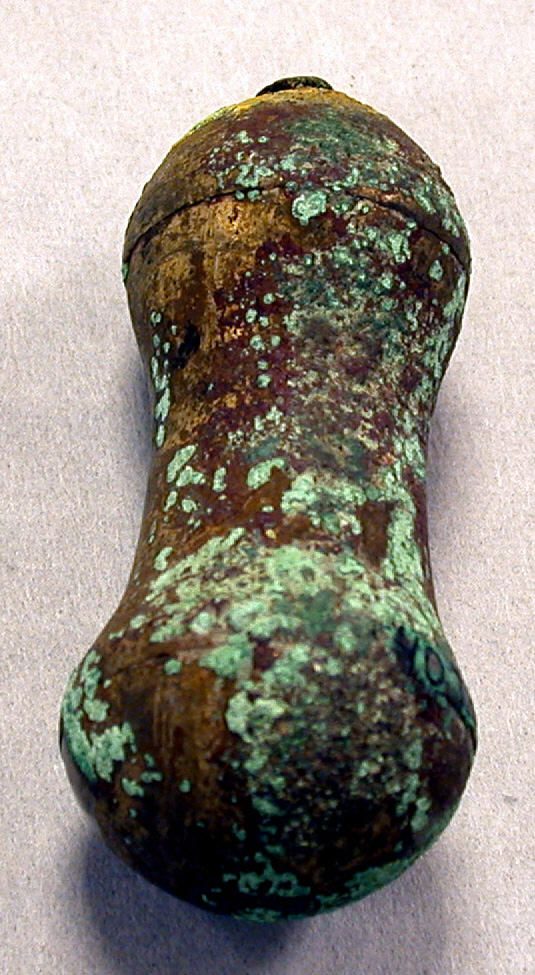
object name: ornament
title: Hammered Silver Peanut Ornament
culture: peruvian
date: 701-1566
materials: gilt, silver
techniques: hammering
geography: peru